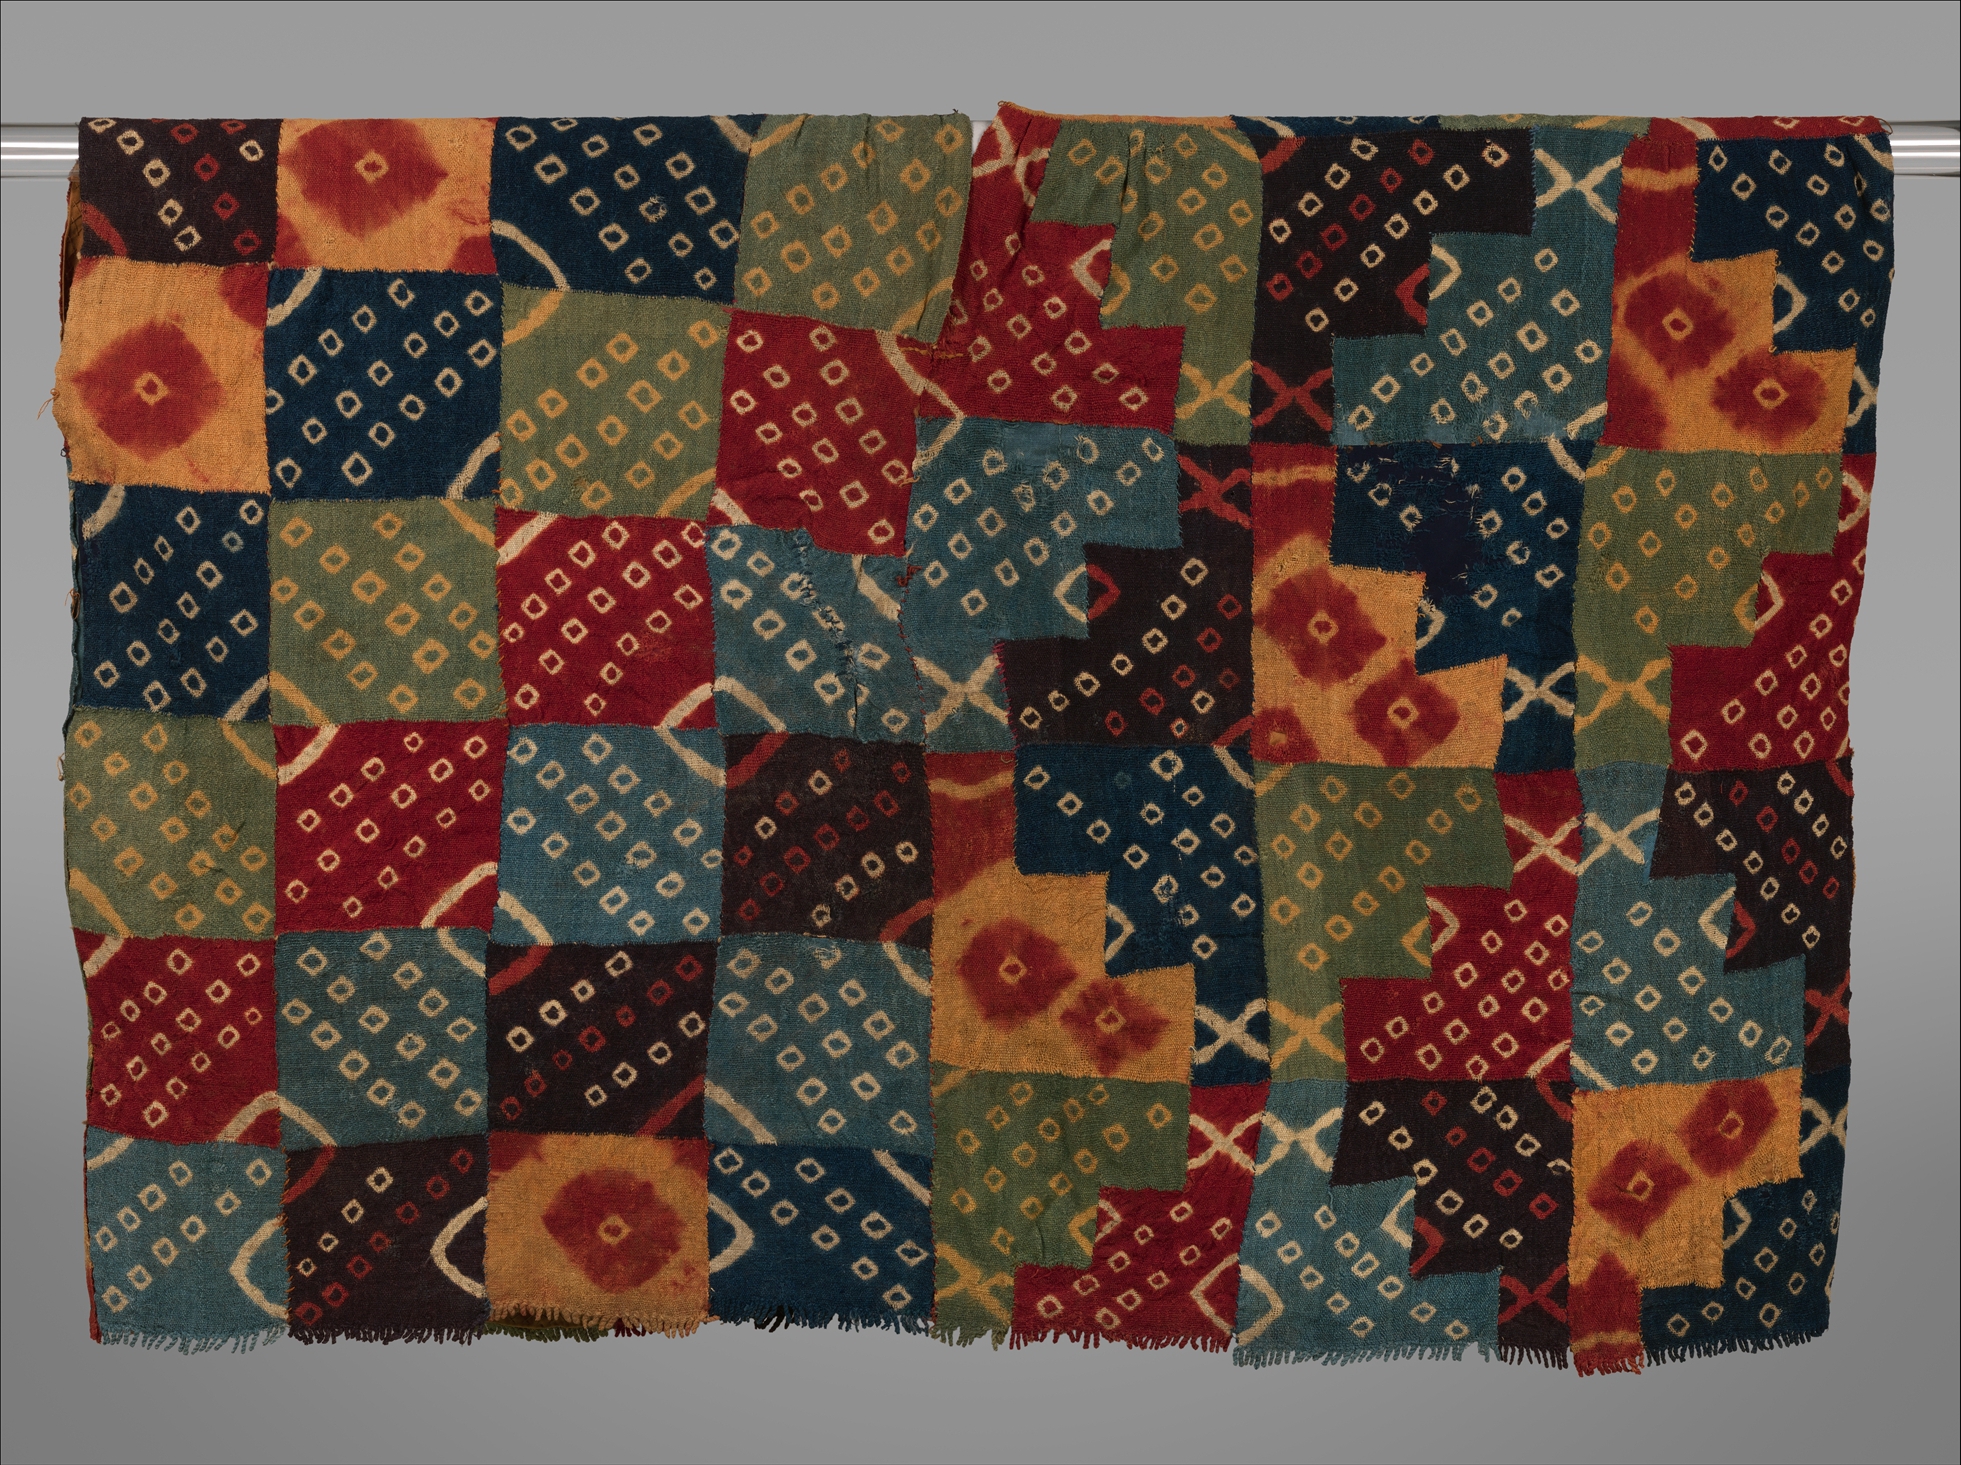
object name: tunic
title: Tie-Dye Tunic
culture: wari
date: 734-866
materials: animal fiber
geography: peru